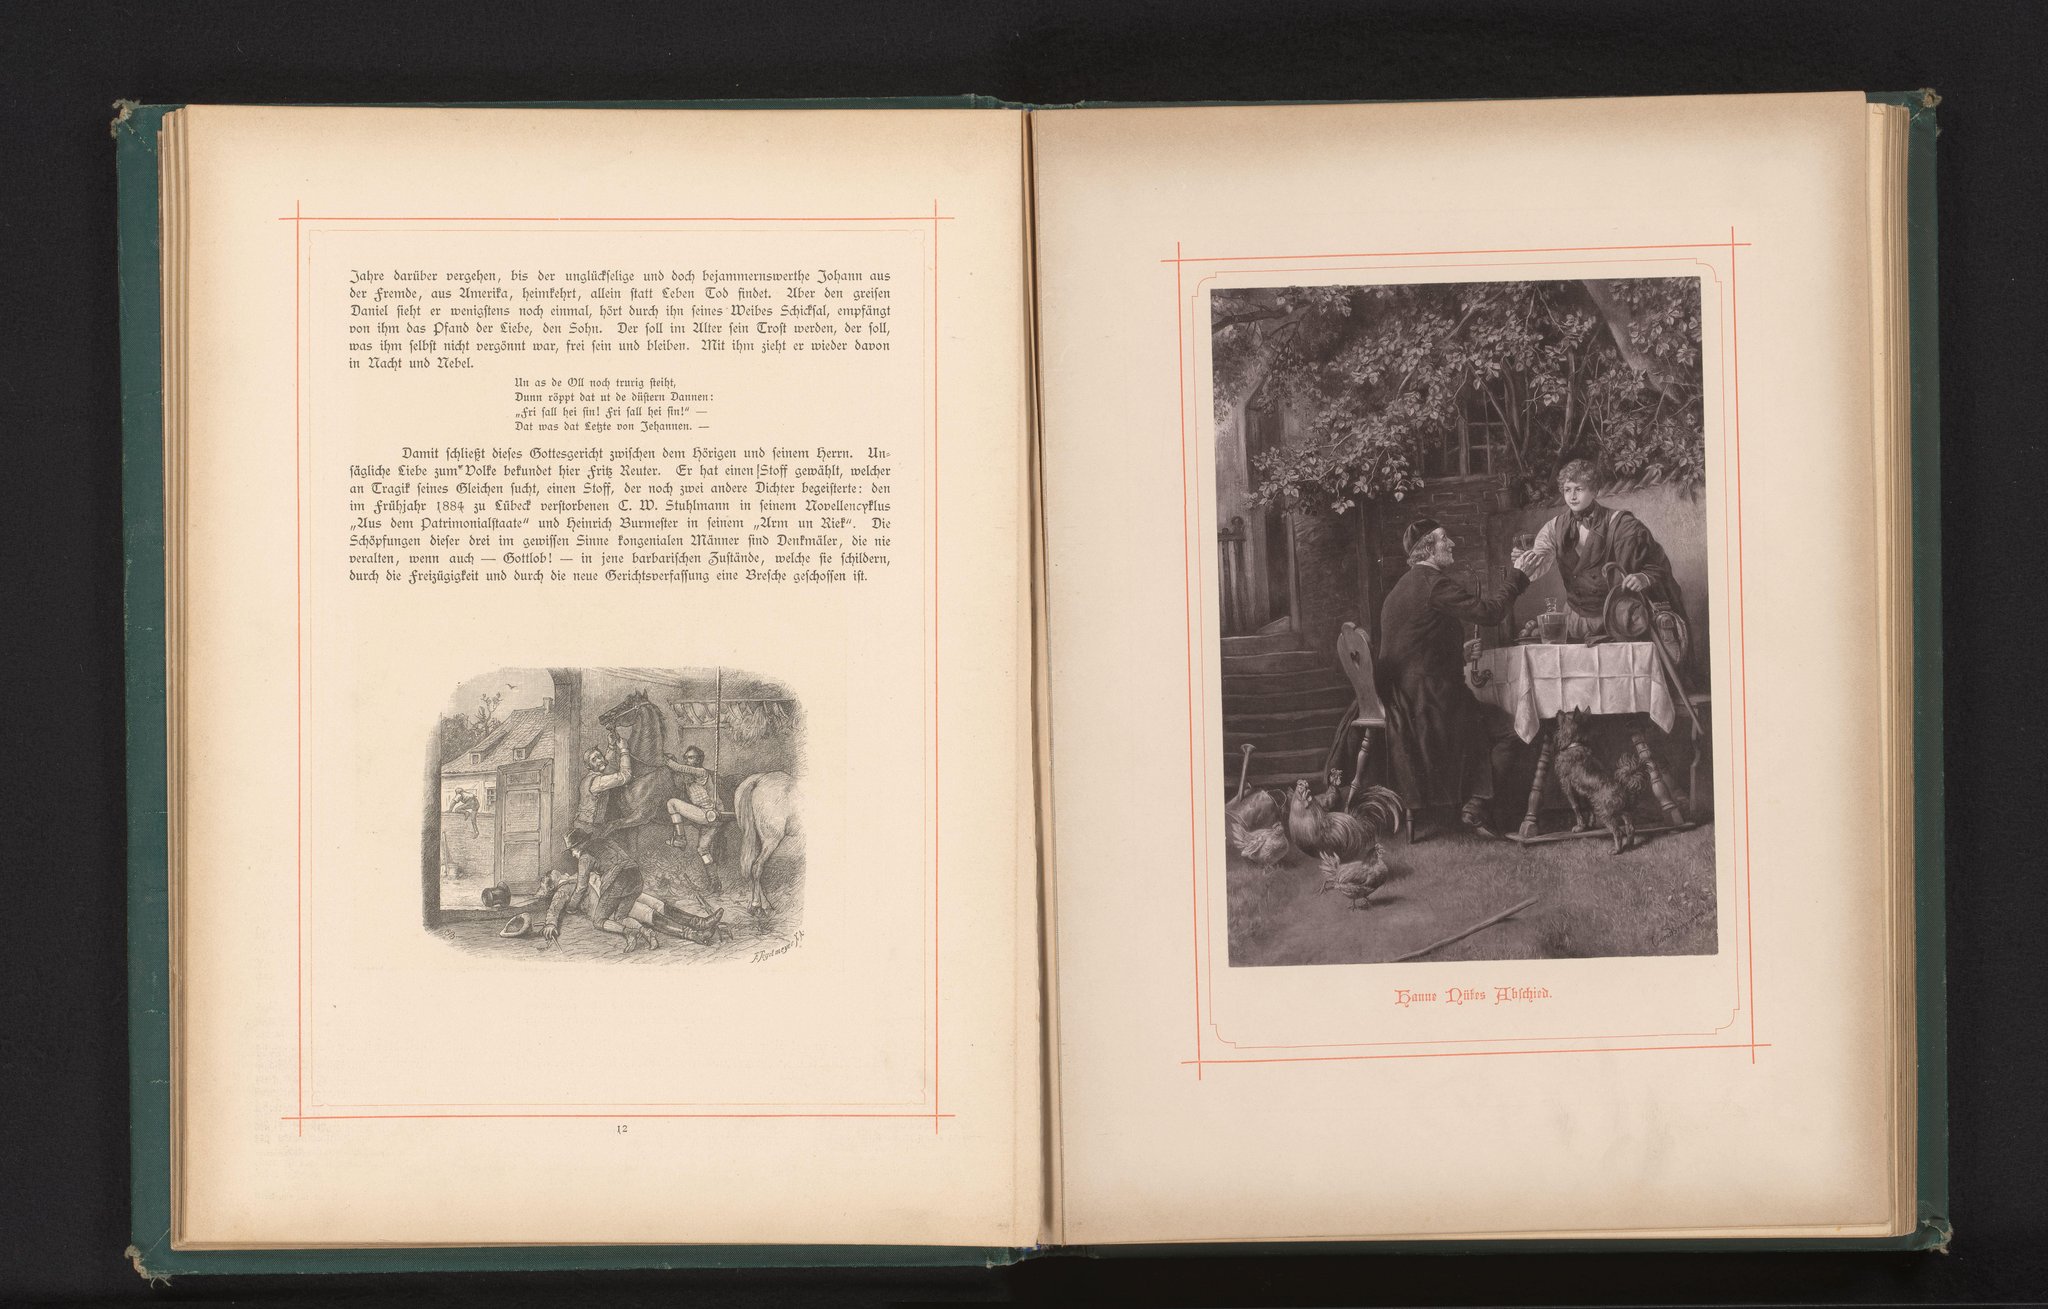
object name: photomechanical print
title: Hanne Nütes Abschied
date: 1874-1884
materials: paper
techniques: photograph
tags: fowl (cock, hen, chicken, etc.), picture, painting, drinking, dog